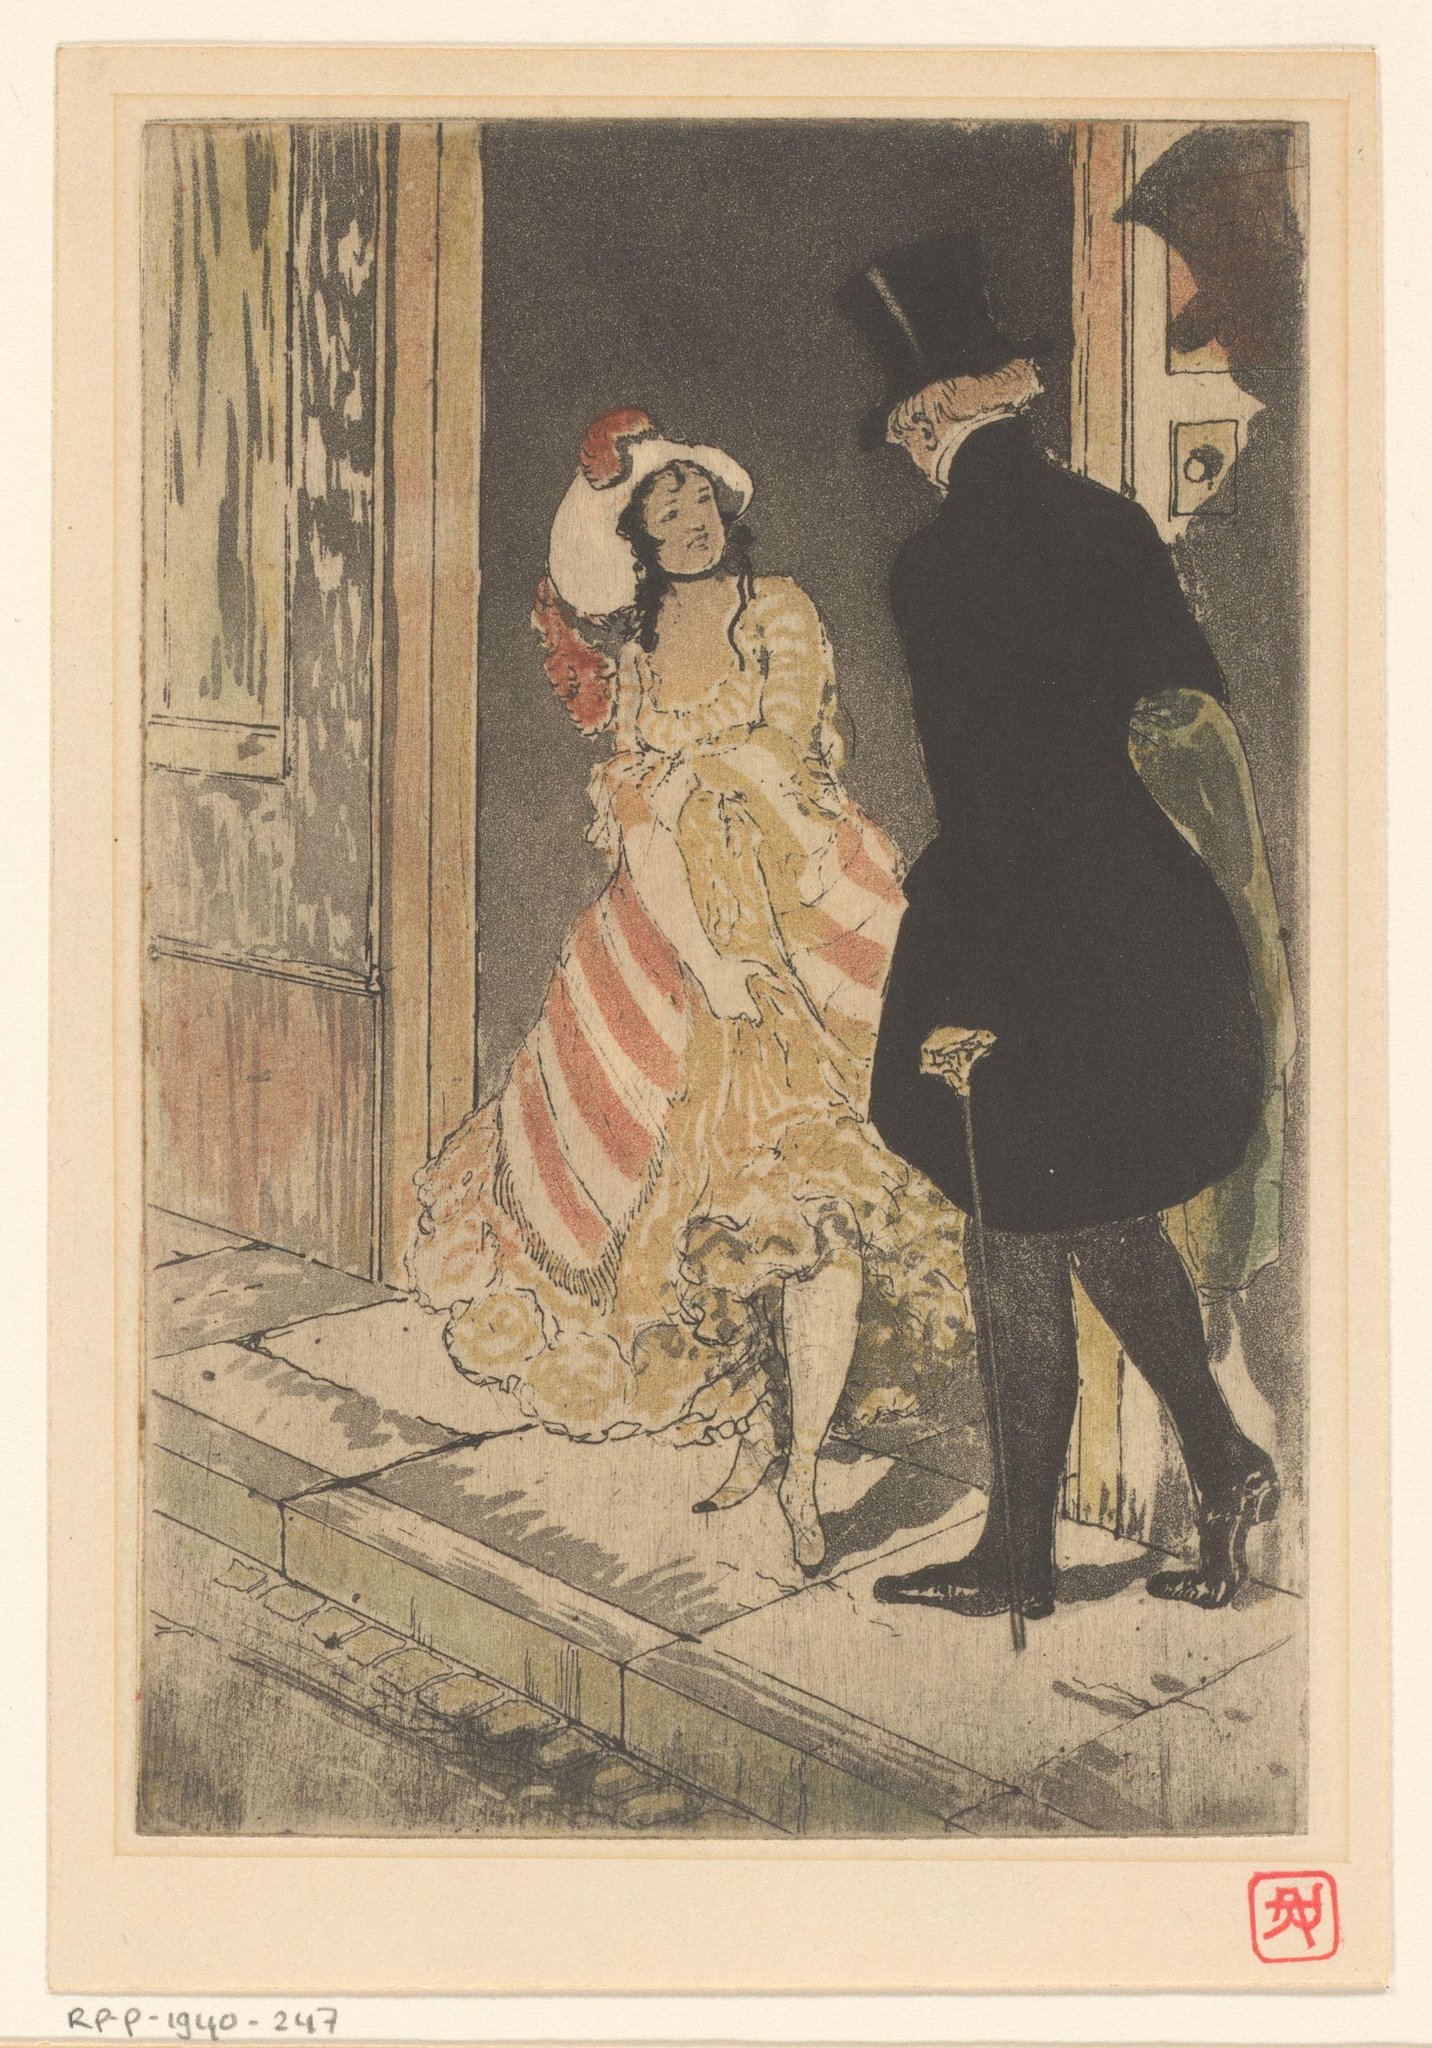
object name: print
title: Man en vrouw op straat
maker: armand rassenfosse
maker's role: draughtsman, painter, print maker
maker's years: 1862-1934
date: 1872-1934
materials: paper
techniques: aquatint, etching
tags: adult woman, adult man, street, head-gear: top hat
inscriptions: collector's mark: Lugt 2228, monogram: Lugt 169